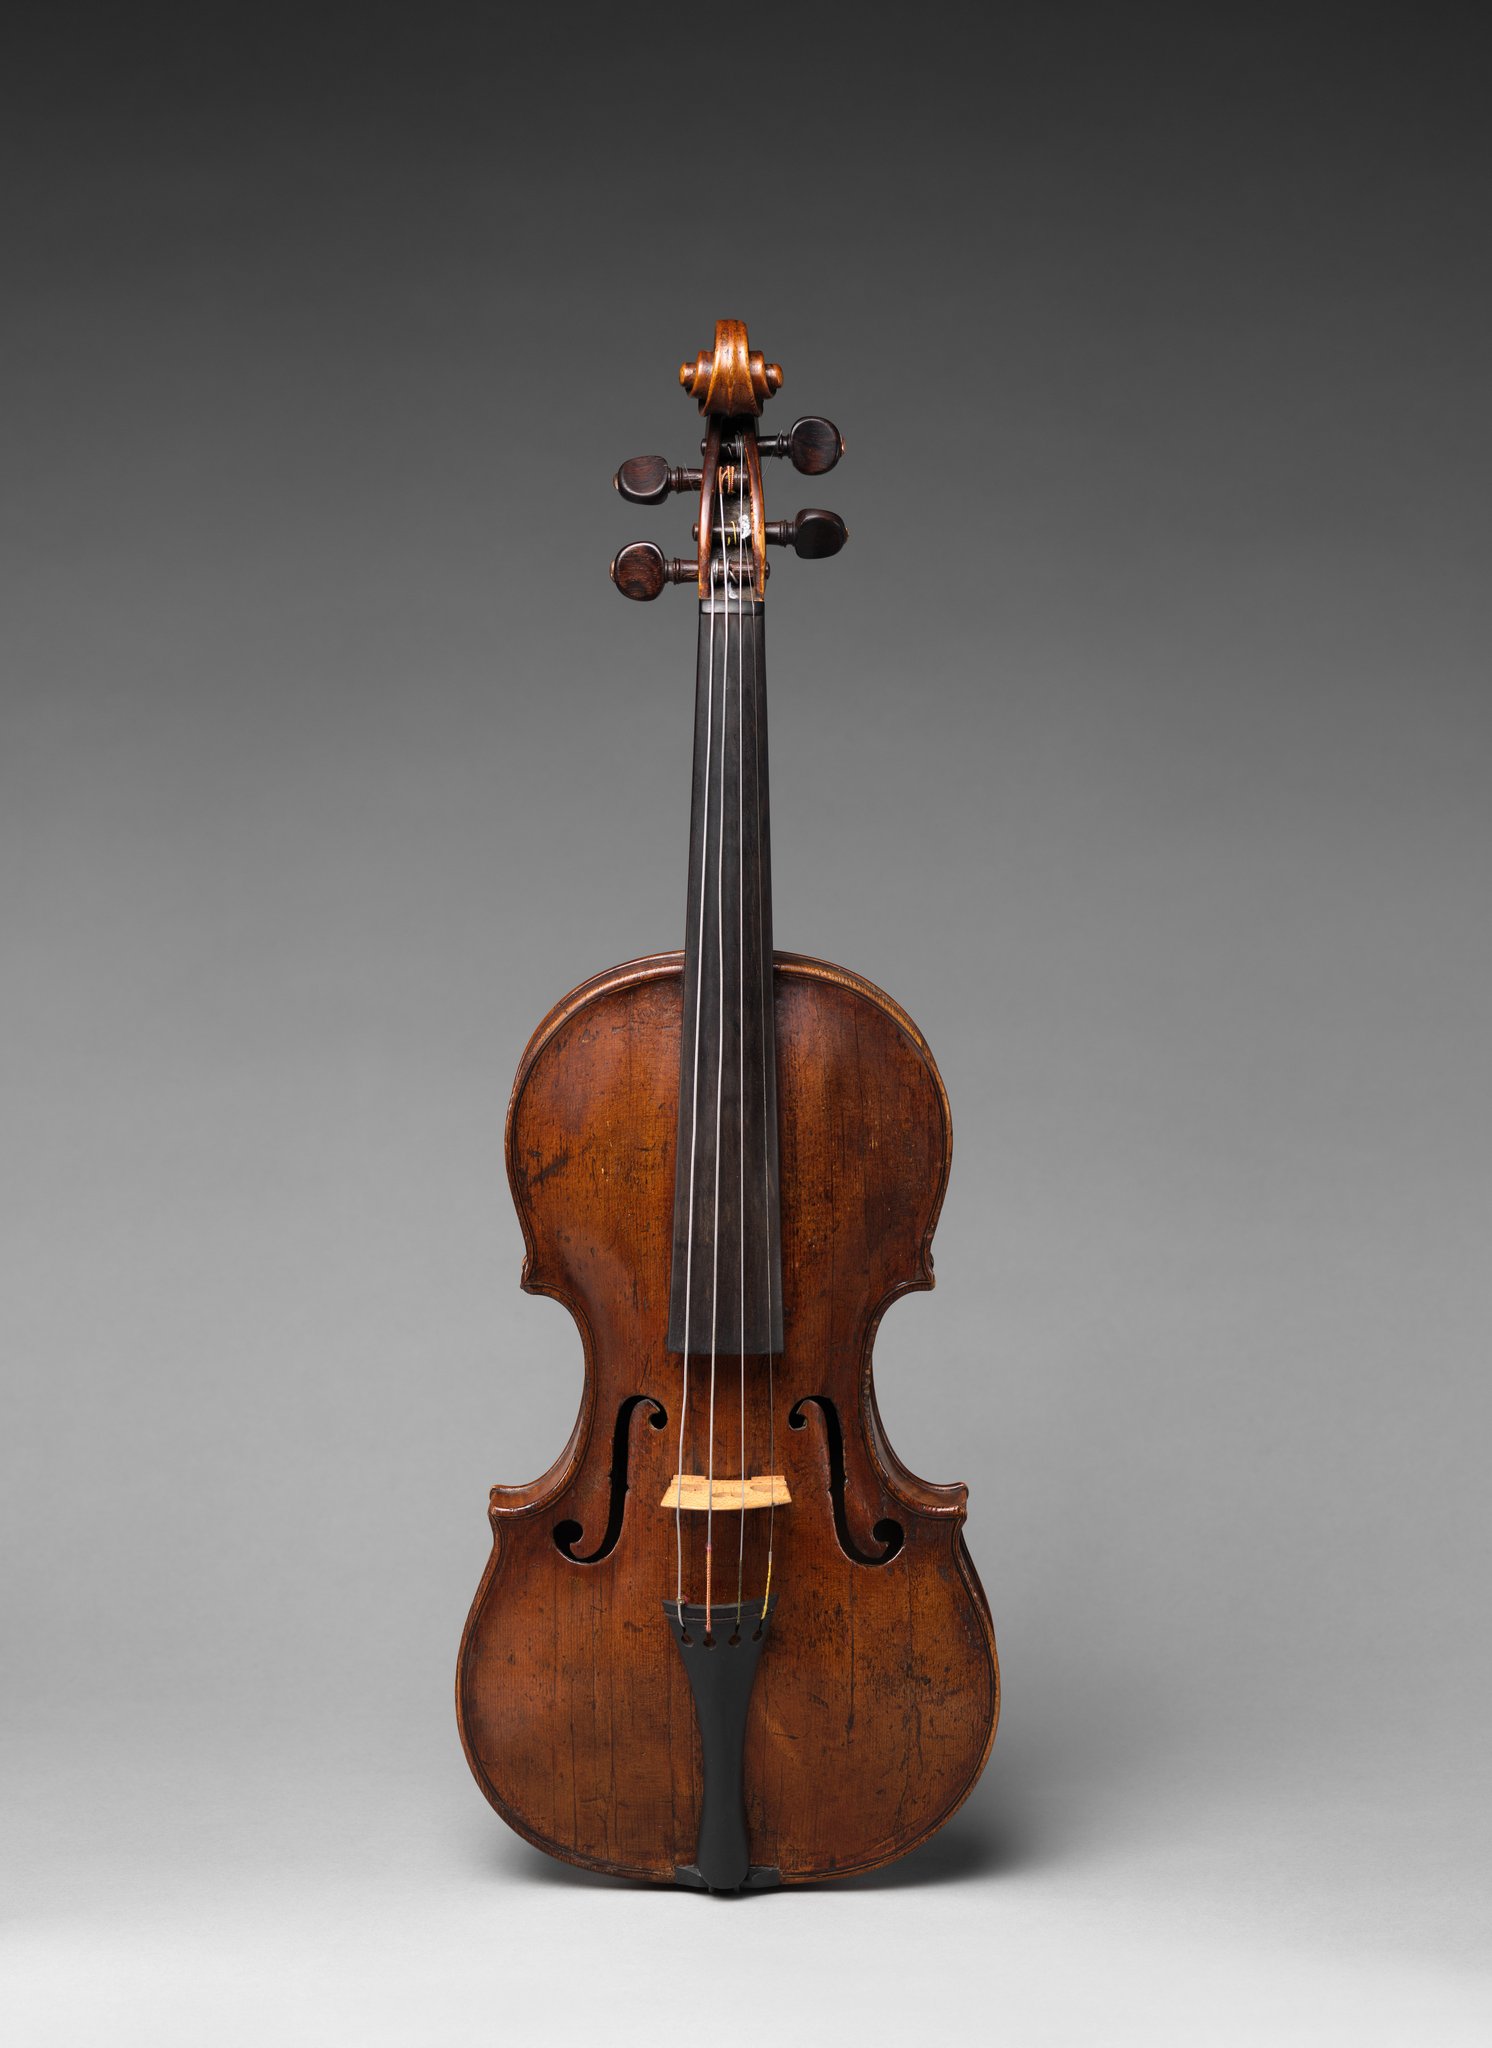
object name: violin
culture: italian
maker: lorenzo carcassi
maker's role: maker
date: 1752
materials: wood